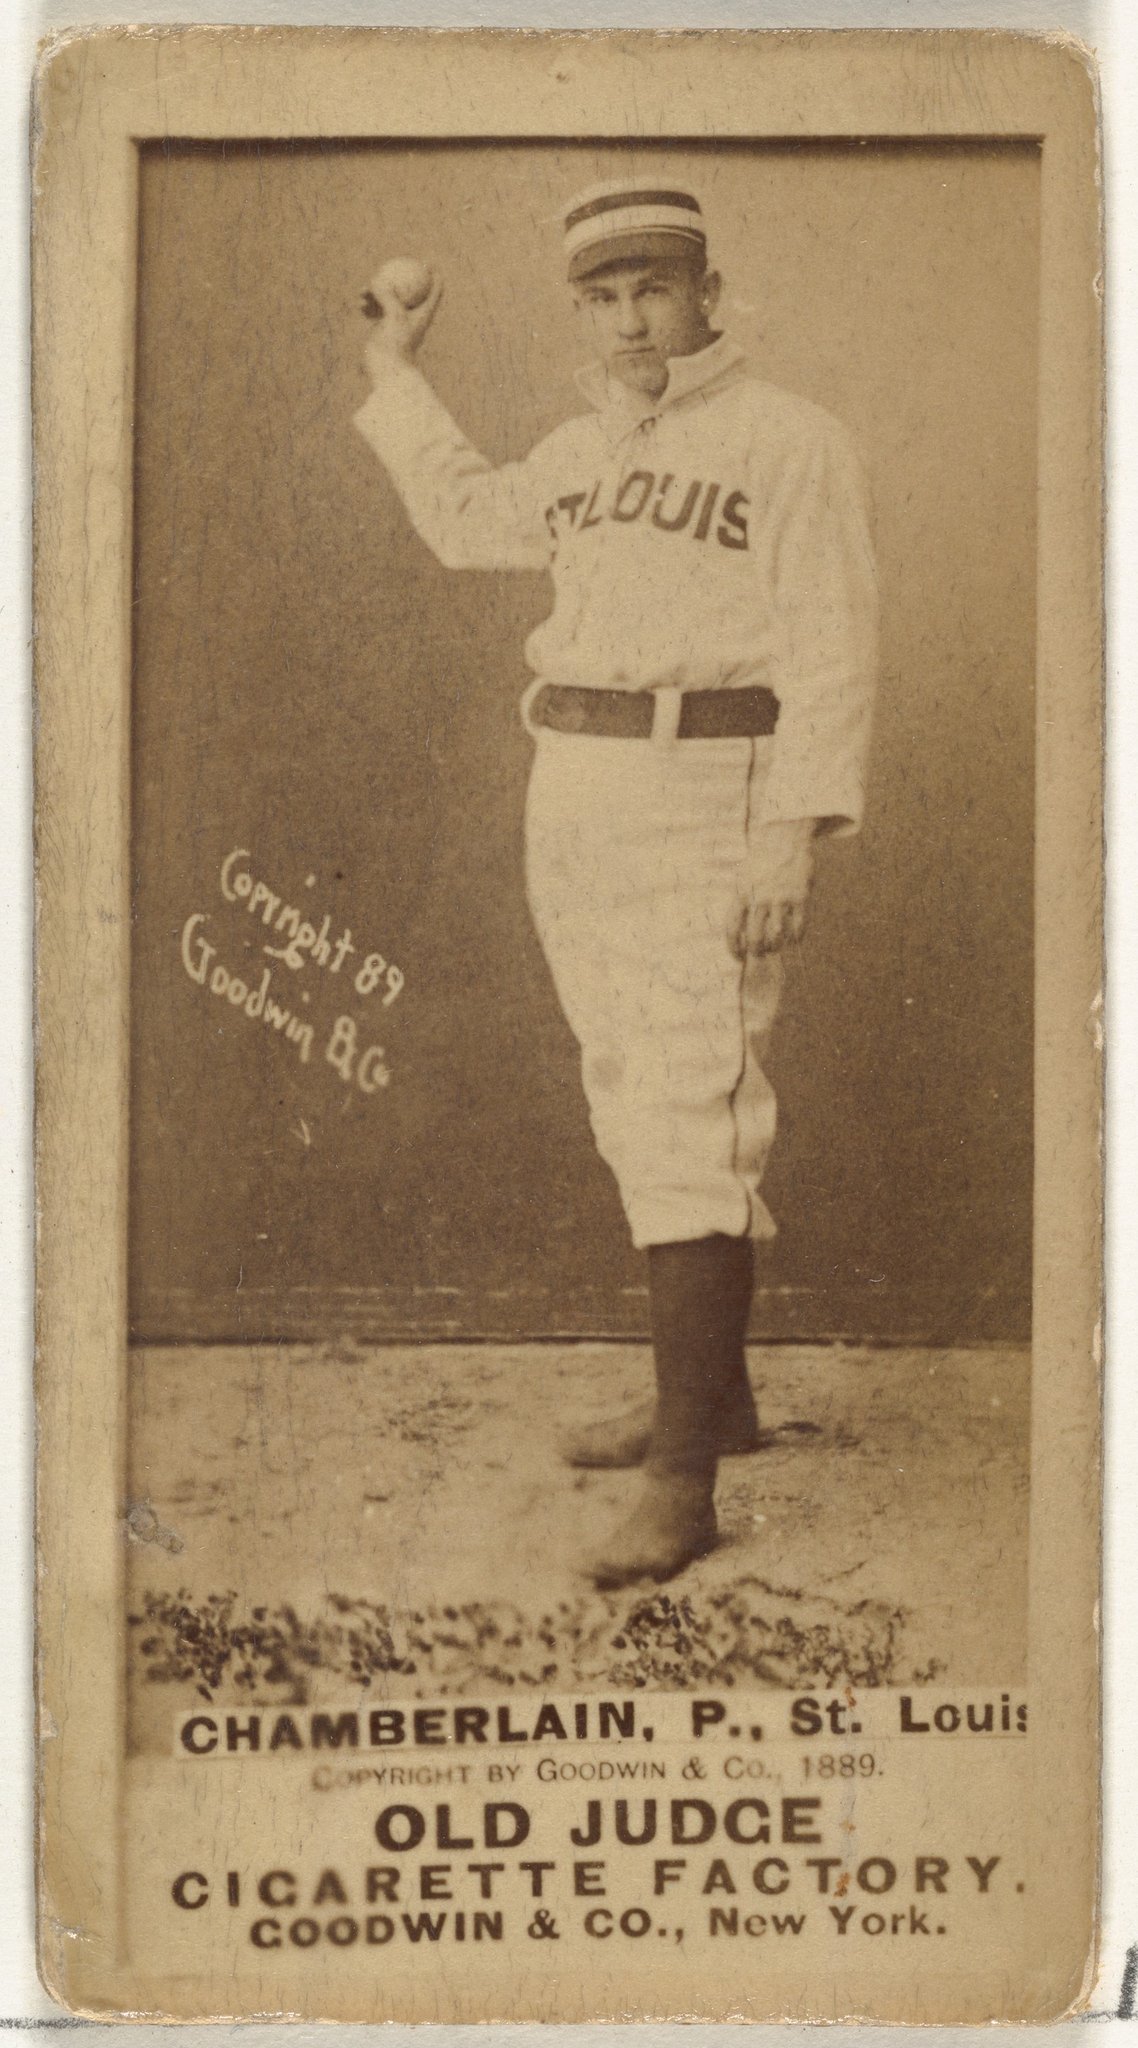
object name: baseball card, photograph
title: Elton P. "Ice Box" Chamberlain, Pitcher, St. Louis Browns, from the Old Judge series (N172) for Old Judge Cigarettes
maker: goodwin & company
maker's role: publisher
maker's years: 1850-1950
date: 1889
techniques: albumen silver print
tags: men,portraits,baseball,athletes